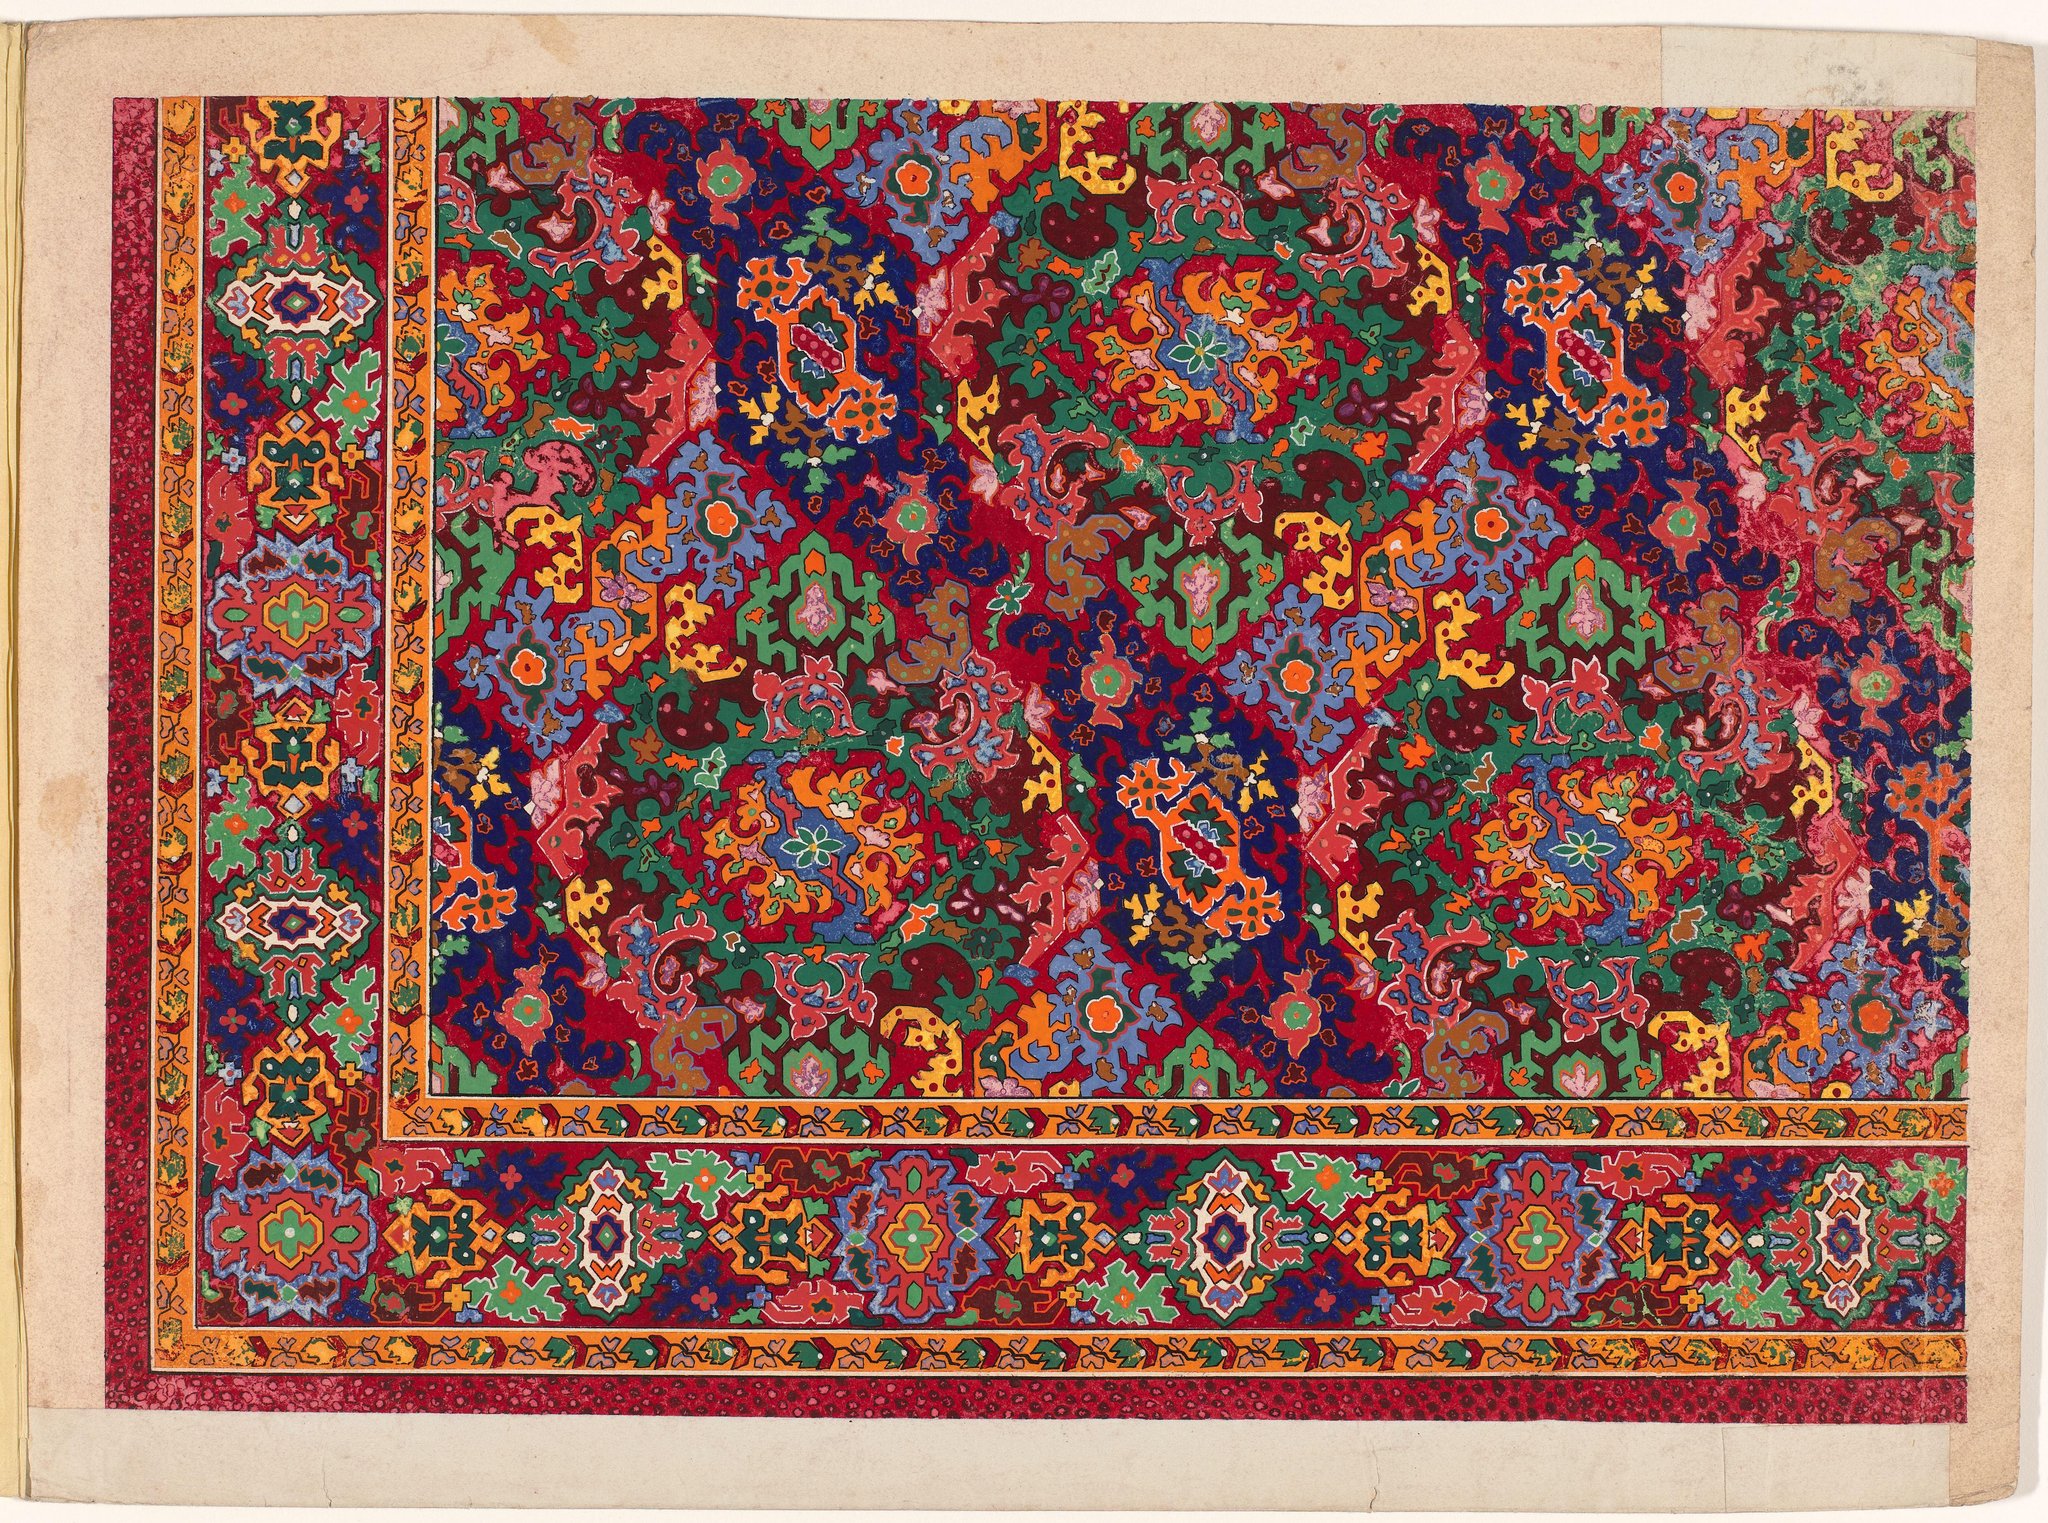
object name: design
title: Ontwerp voor een tapijt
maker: Anonymous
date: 1854-1864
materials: gouache, paper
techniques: brush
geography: deventer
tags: ornaments ~ art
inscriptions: number: ‘No 363.’, retailer's mark: ‘JHS.’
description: De presentatietekeningen BK-1971-77-1 t/m 86 zijn kopieën van de originele ontwerptekeningen. Ze werden gemaakt voor vertegenwoordigers van bijvoorbeeld magazijnen, die ze aan hun klanten konden tonen. De meeste tekeningen tonen een kwart van het dessin inclusief rand, middenpartij (de zogenaamde grond of fond) en centraal medaillon. Door het gebruik van spiegels kan de illusie van het gehele tapijt worden opgeroepen. Een deel van de tekeningen heeft een alfabetische opeenvolgende letter als kenmerk, de andere groep een cijfer.Waarschijnlijk is de reeks dessins met een letter eerder samengesteld dan de genummerde tekeningen.